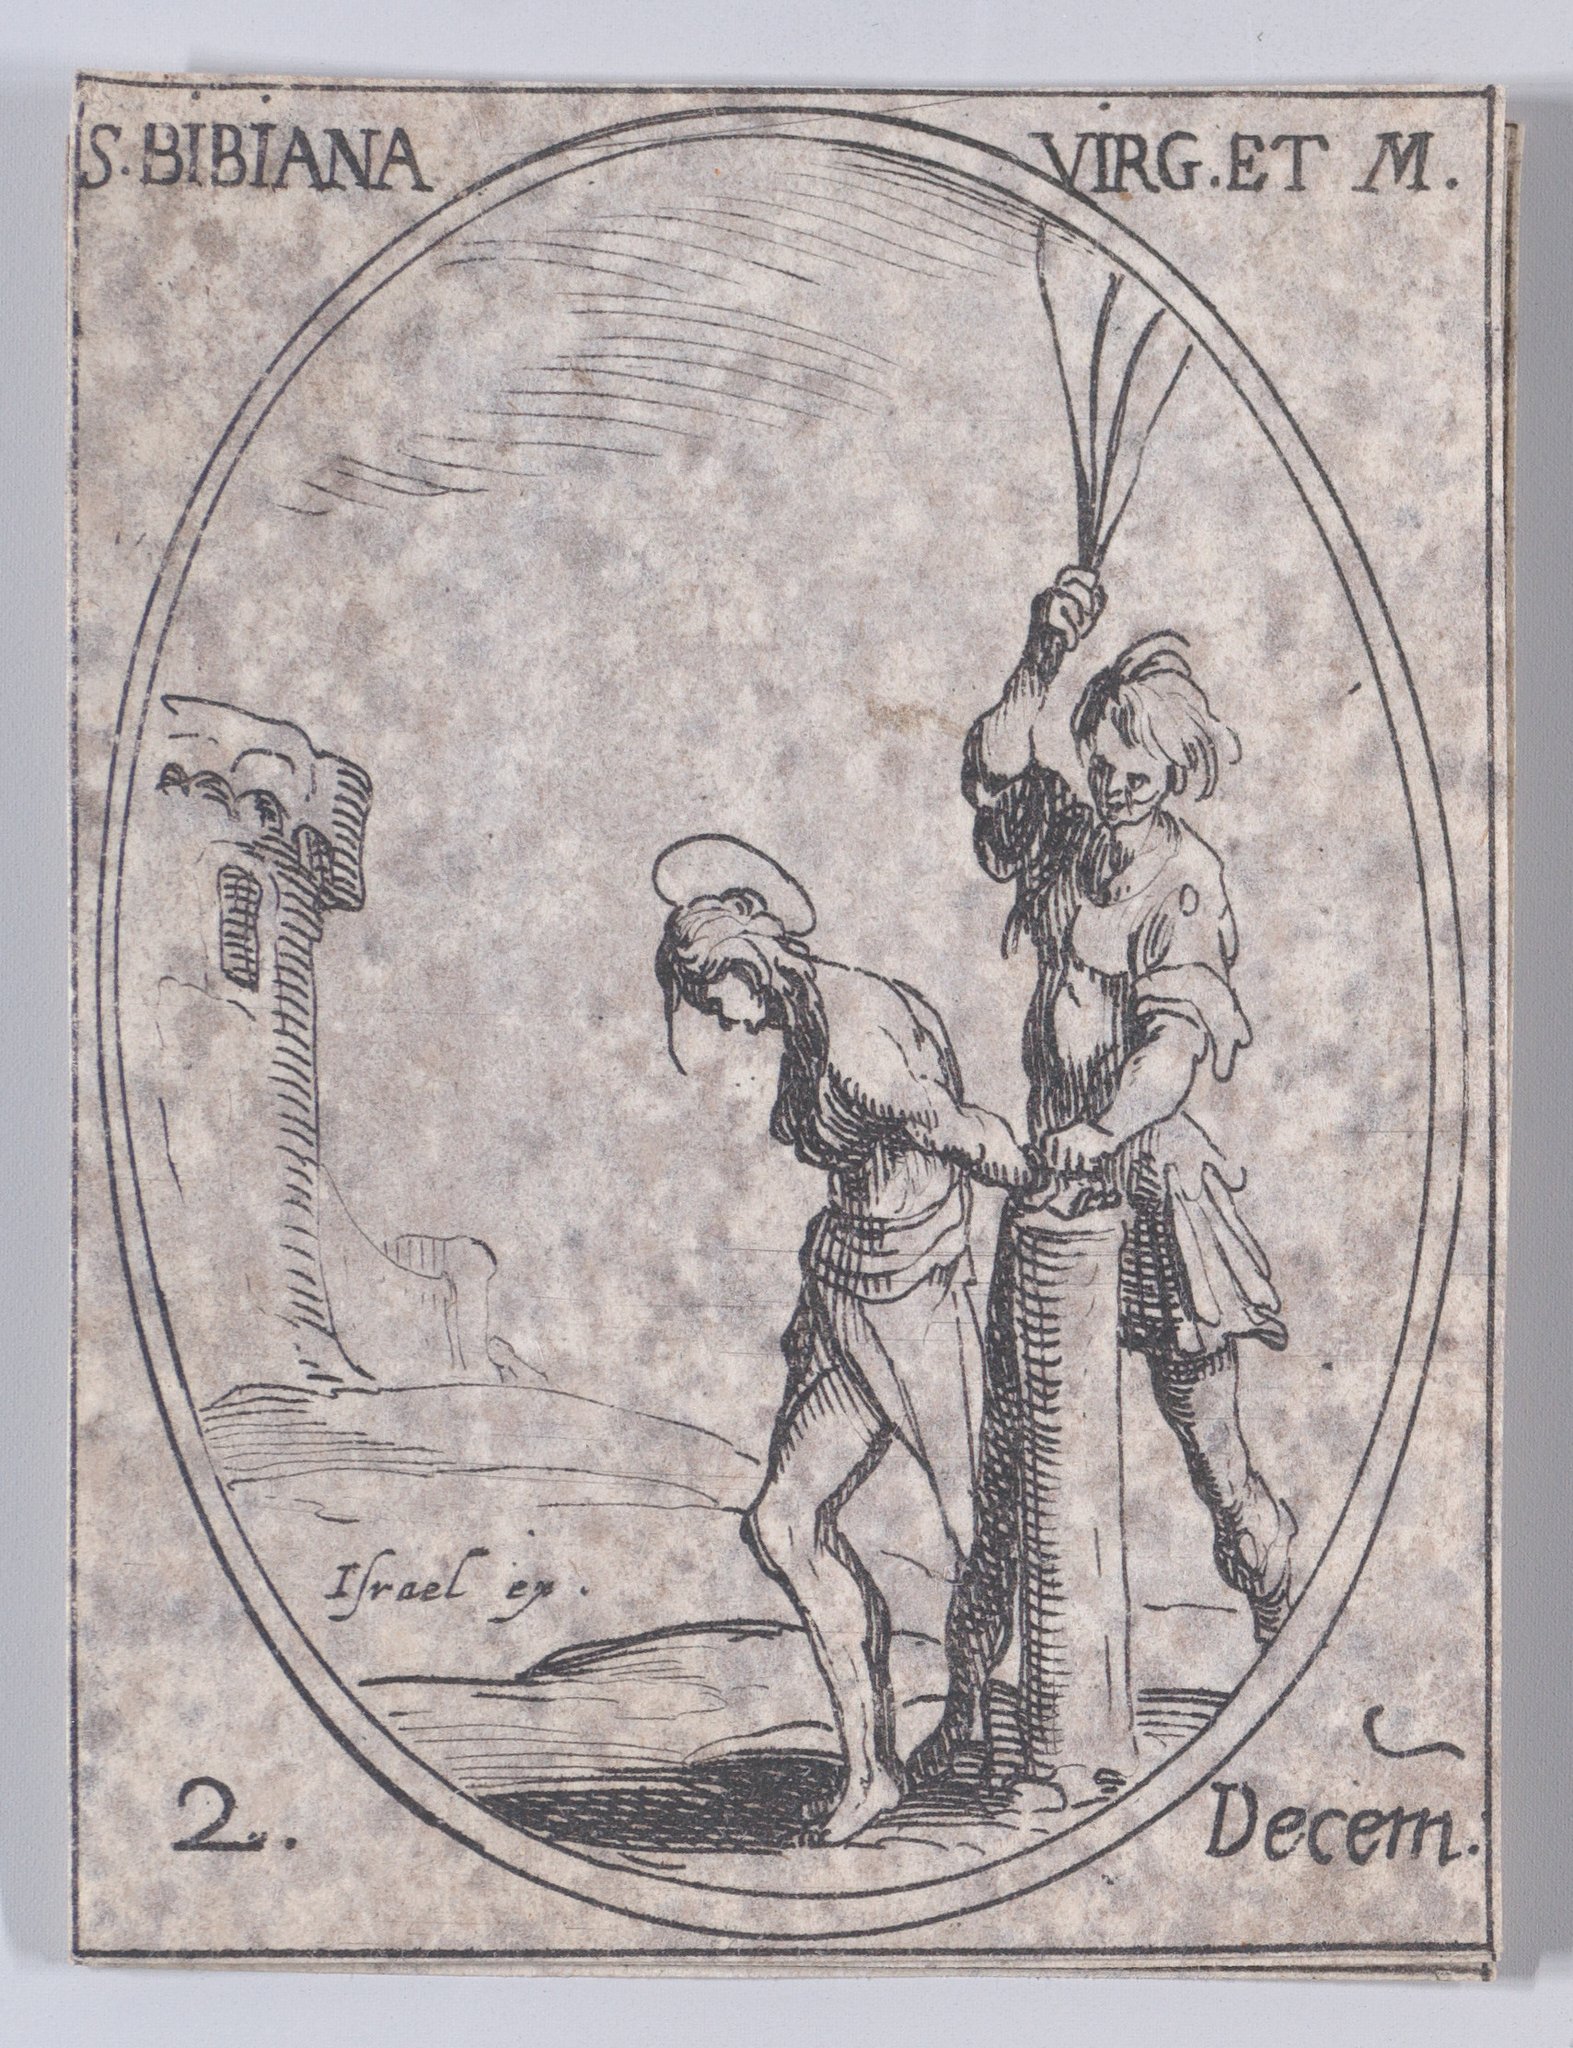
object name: print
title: Ste. Bibienne, vierge et martyre (St. Bibiana, Virgin and Martyr), December 2nd, from "Les Images De Tous Les Saincts et Saintes de L'Année" (Images of All of the Saints and Religious Events of the Year)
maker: jacques callot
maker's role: artist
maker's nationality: french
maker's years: 1592-1635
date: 1636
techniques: etching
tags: men,women,saints